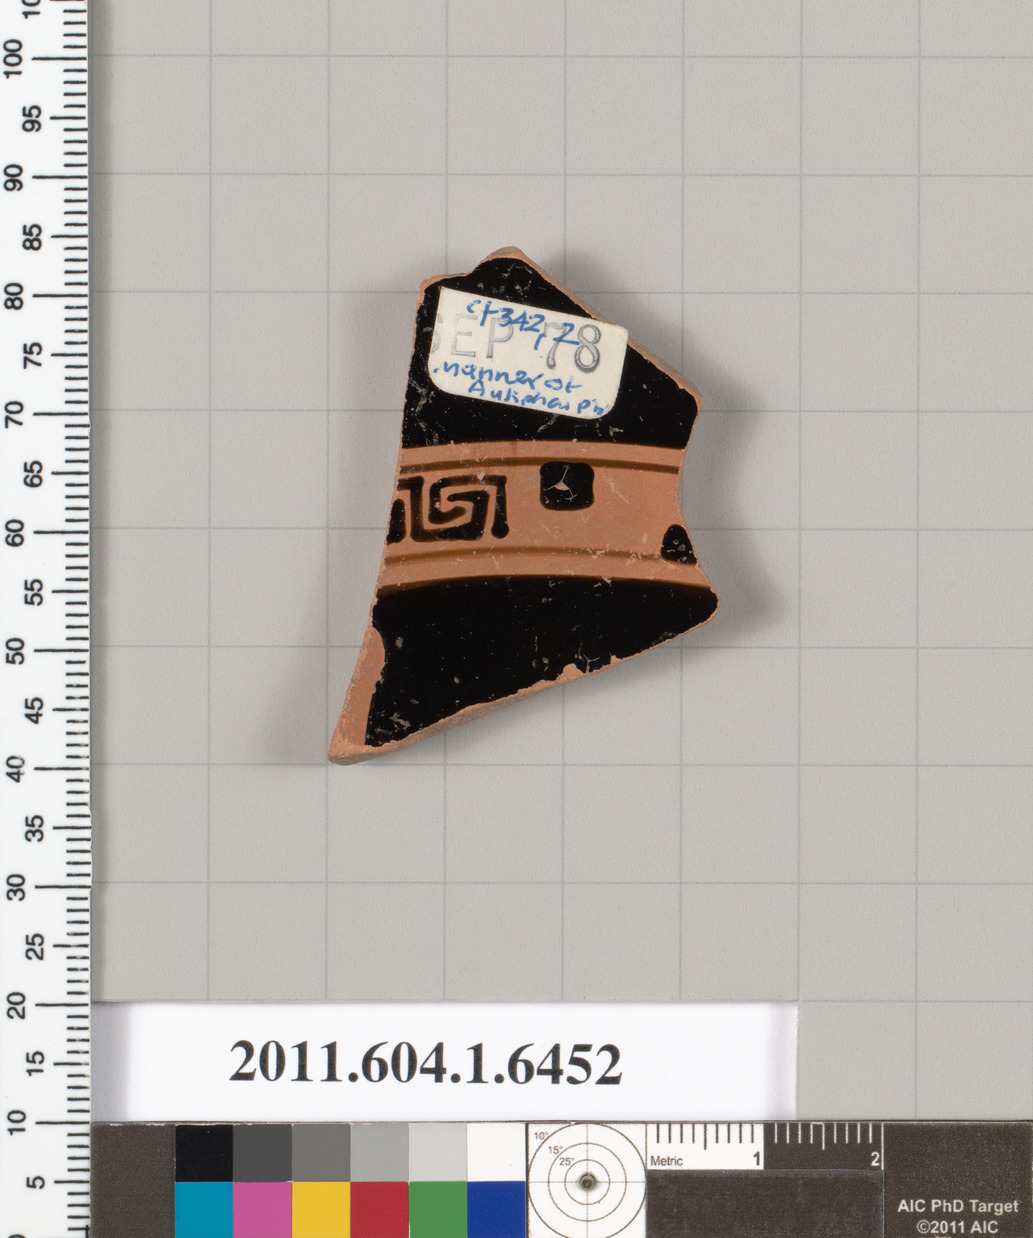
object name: kylix fragment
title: Terracotta fragment of a kylix (drinking cup)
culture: greek, attic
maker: antiphon painter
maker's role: artist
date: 490-480 BCE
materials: terracotta